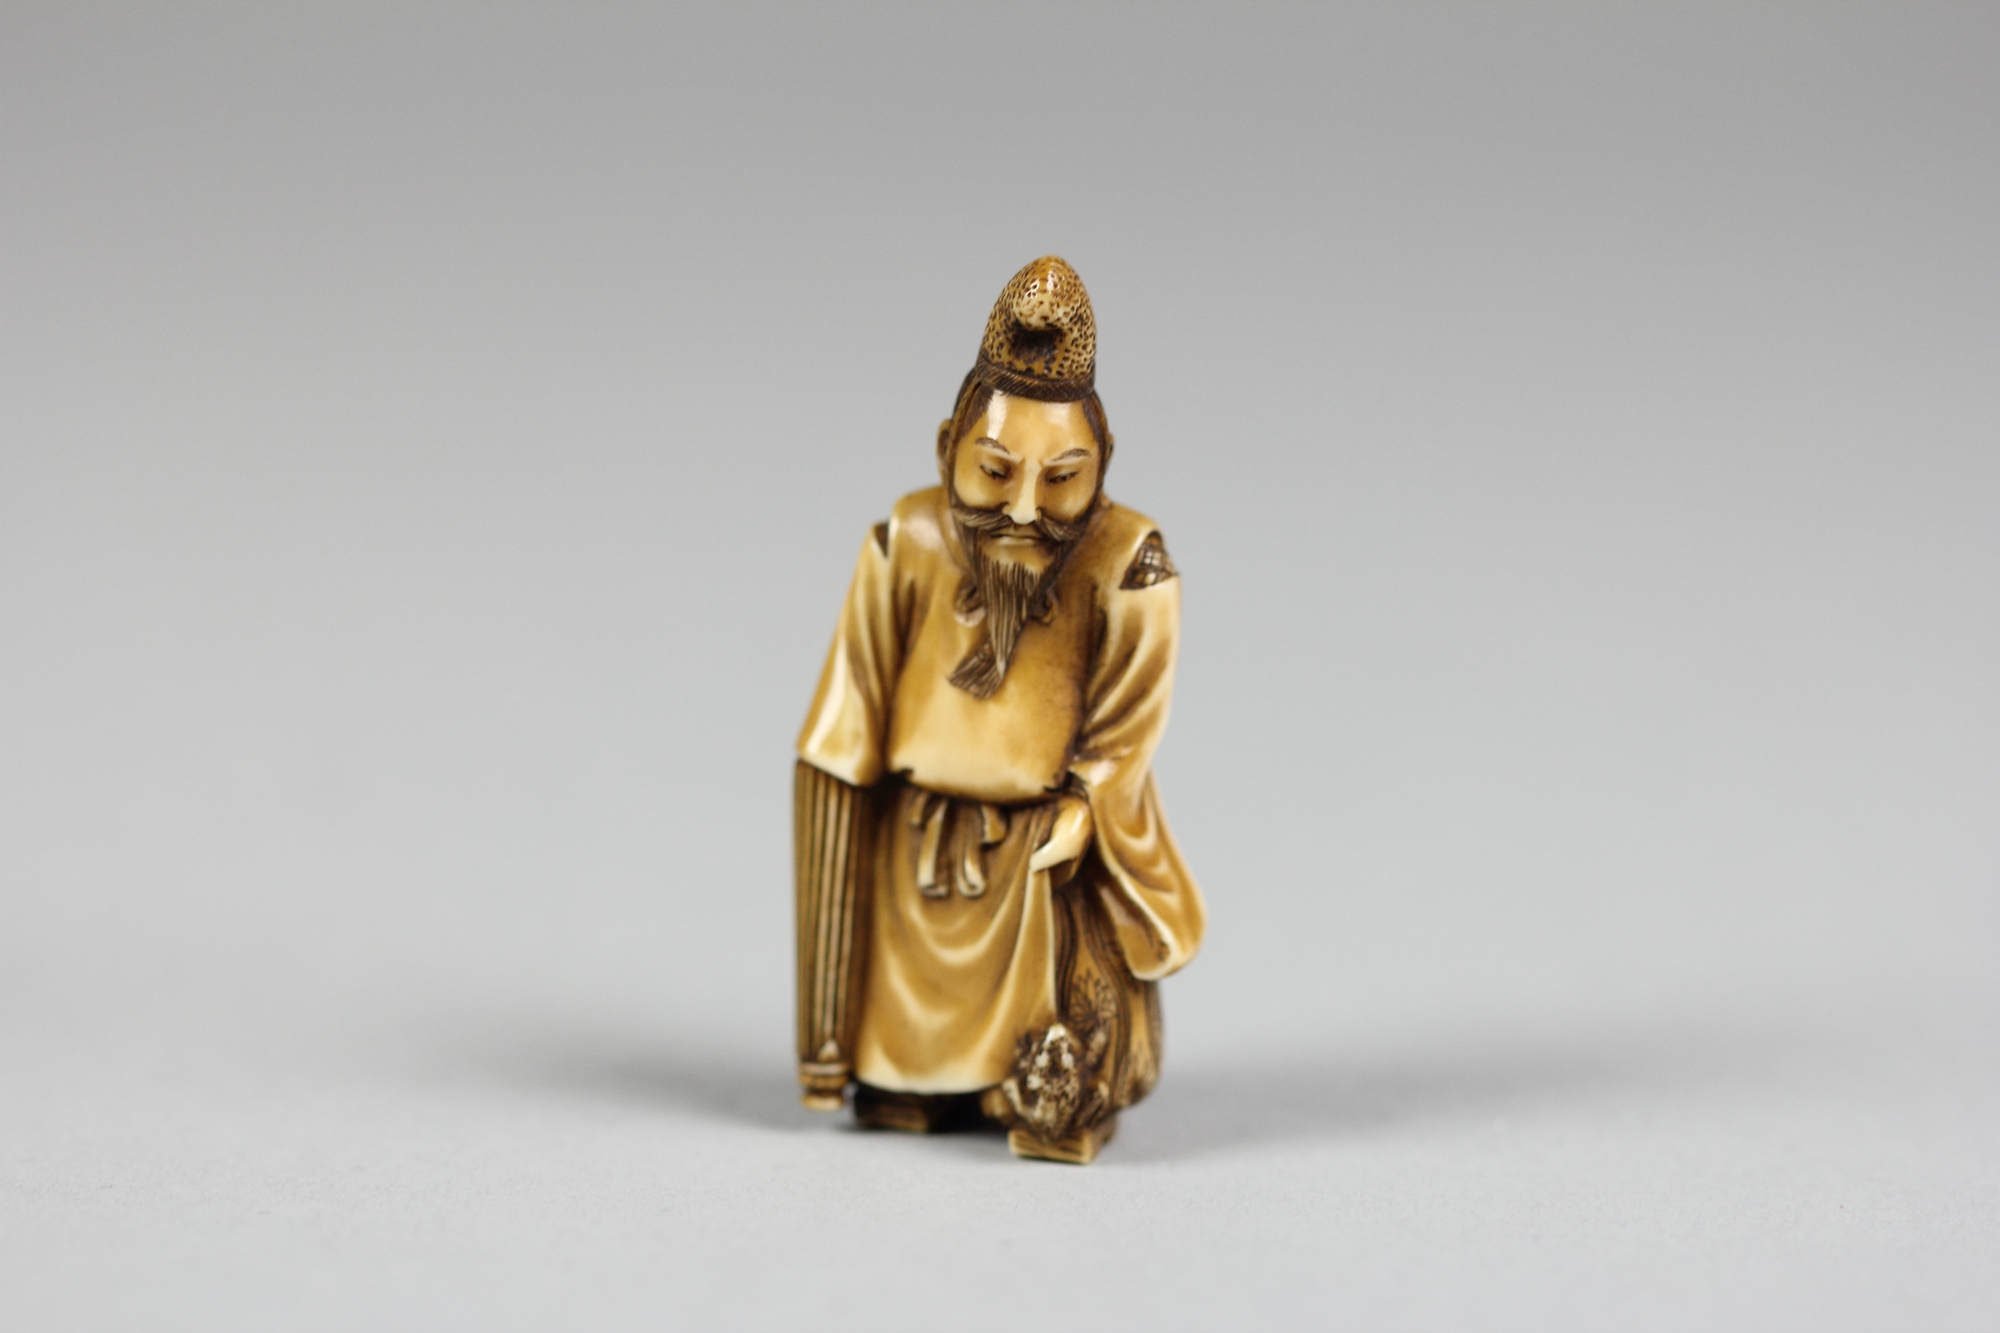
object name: netsuke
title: Netsuke of Onono Tofu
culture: japanese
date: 1701-1900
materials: ivory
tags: men